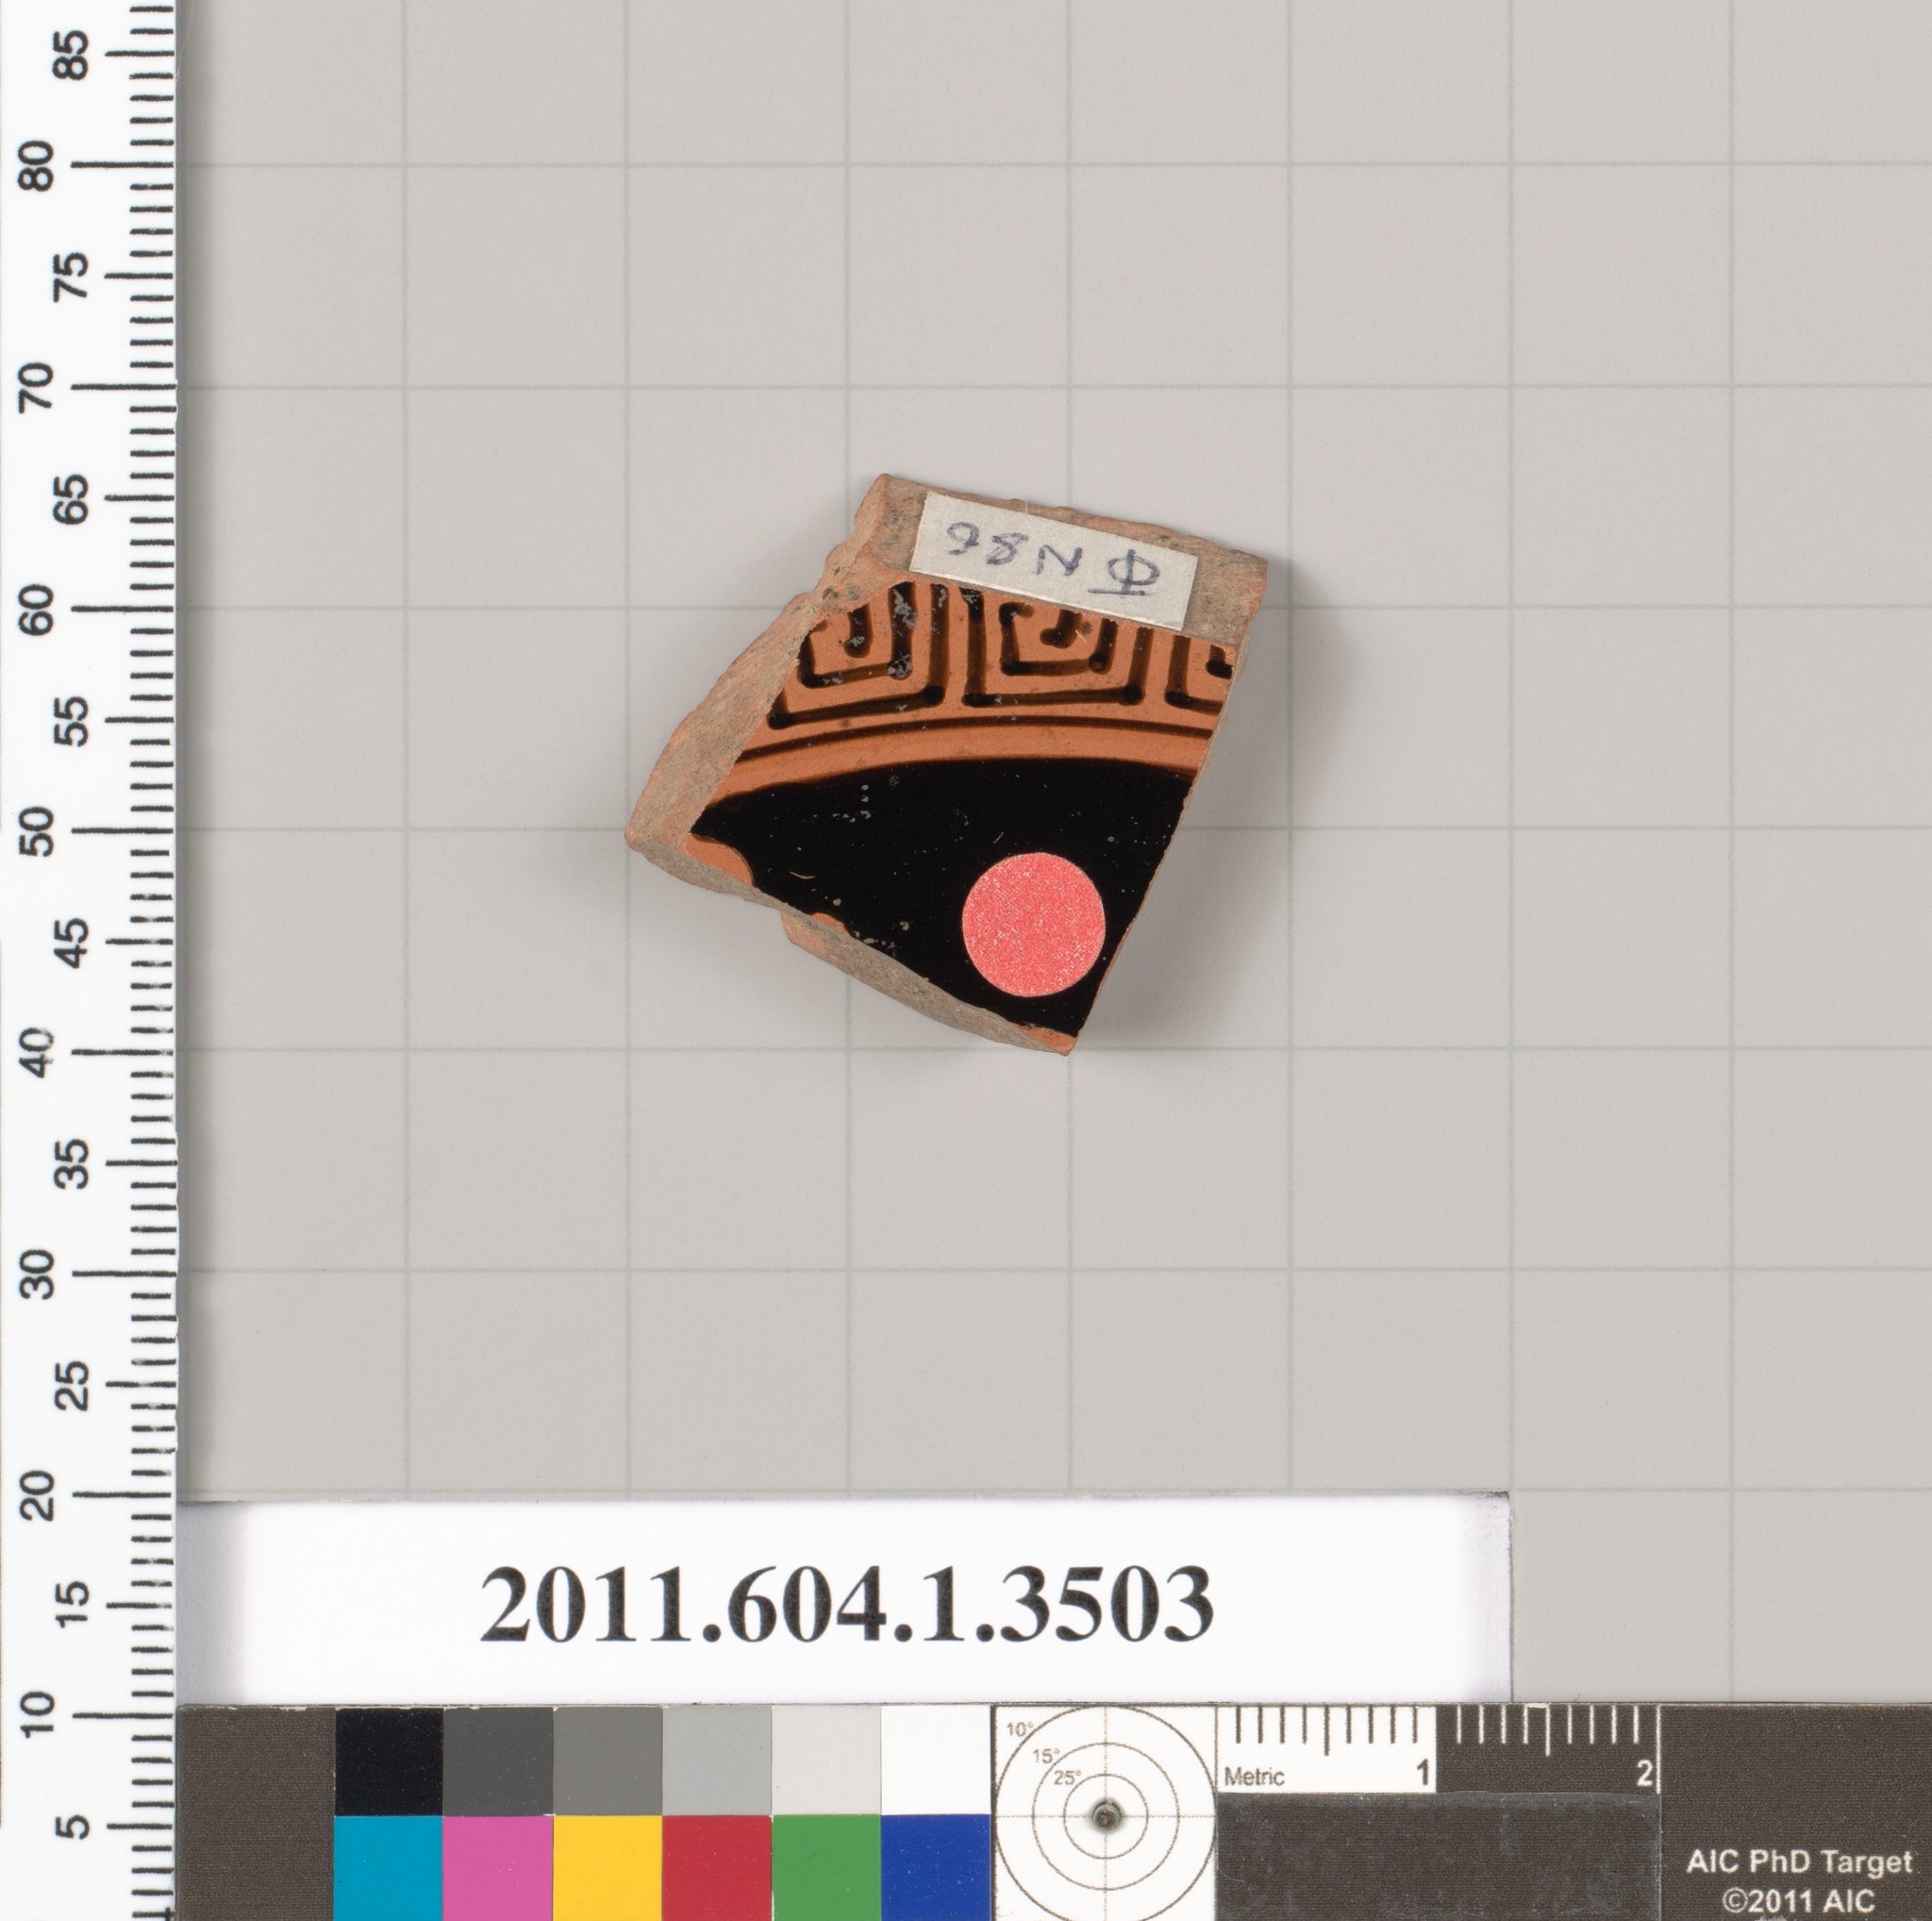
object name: kylix fragment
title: Terracotta fragment of a kylix (drinking cup)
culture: greek, attic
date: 490-480 BCE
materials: terracotta